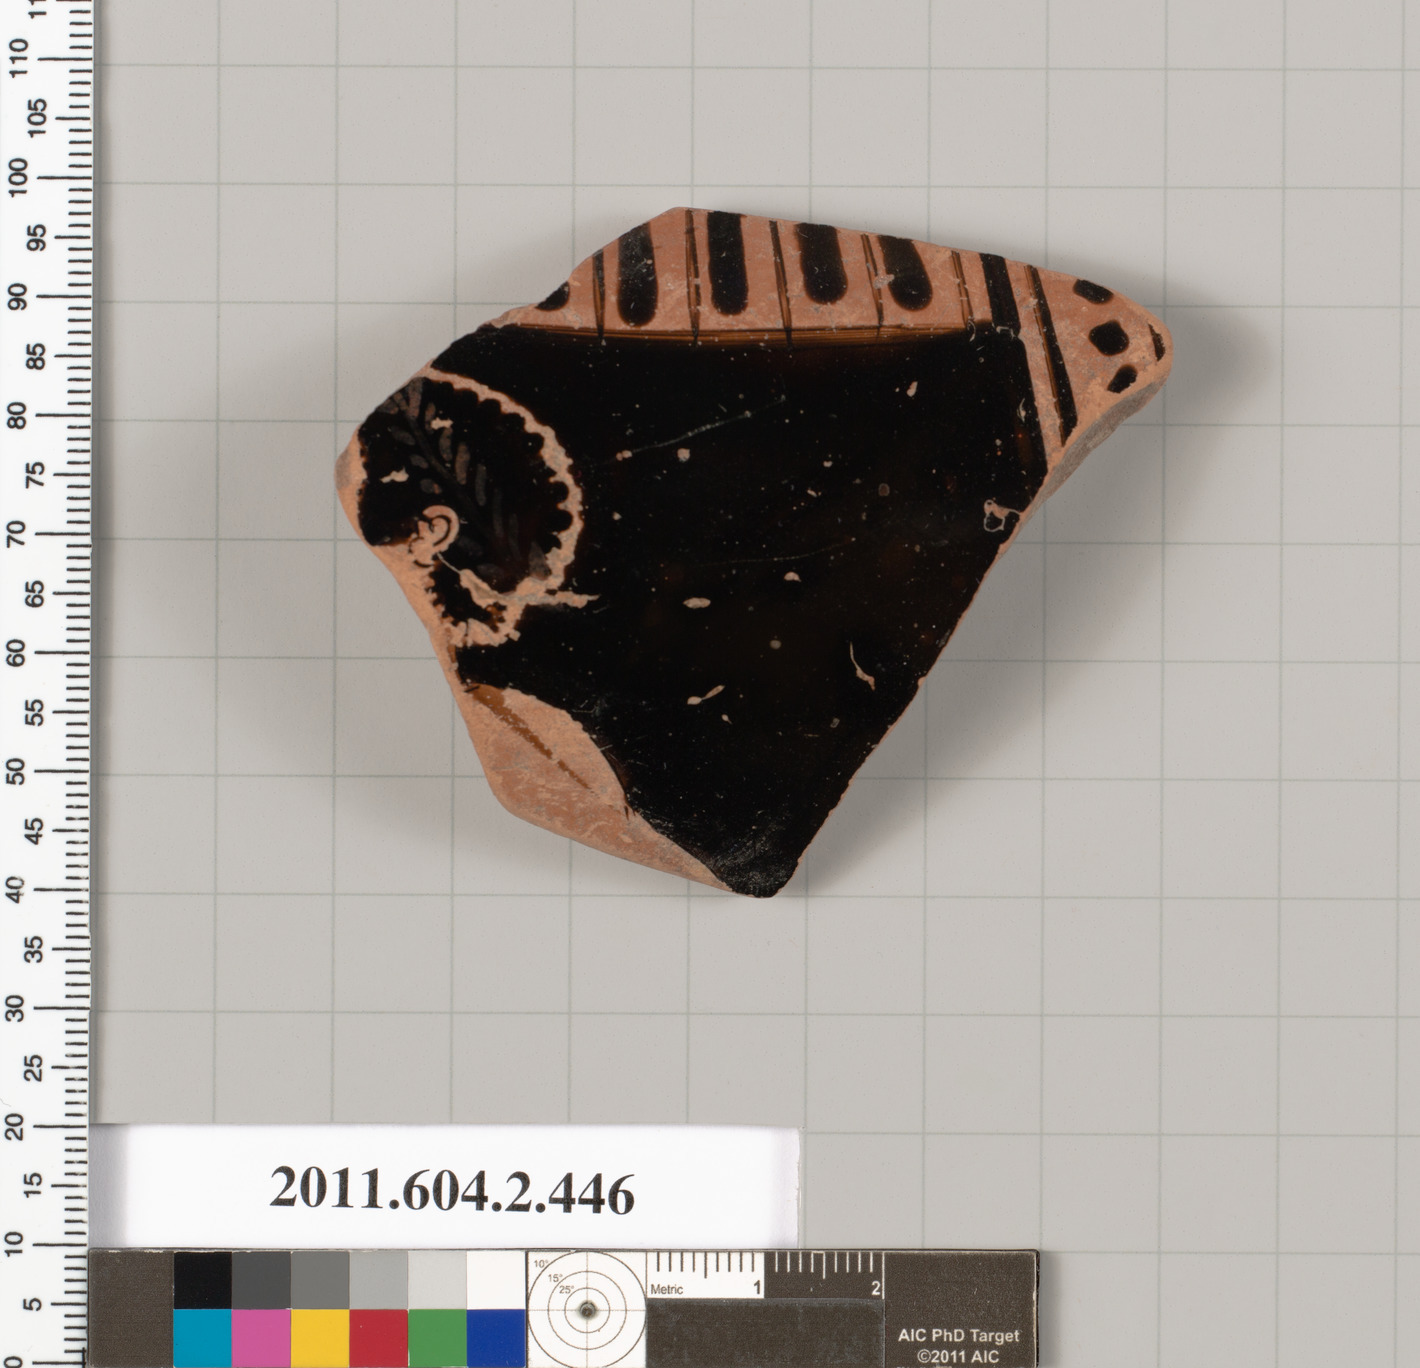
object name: column krater fragment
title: Terracotta fragment of a column-krater (bowl for mixing wine and water)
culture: greek, attic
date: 470-450 BCE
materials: terracotta